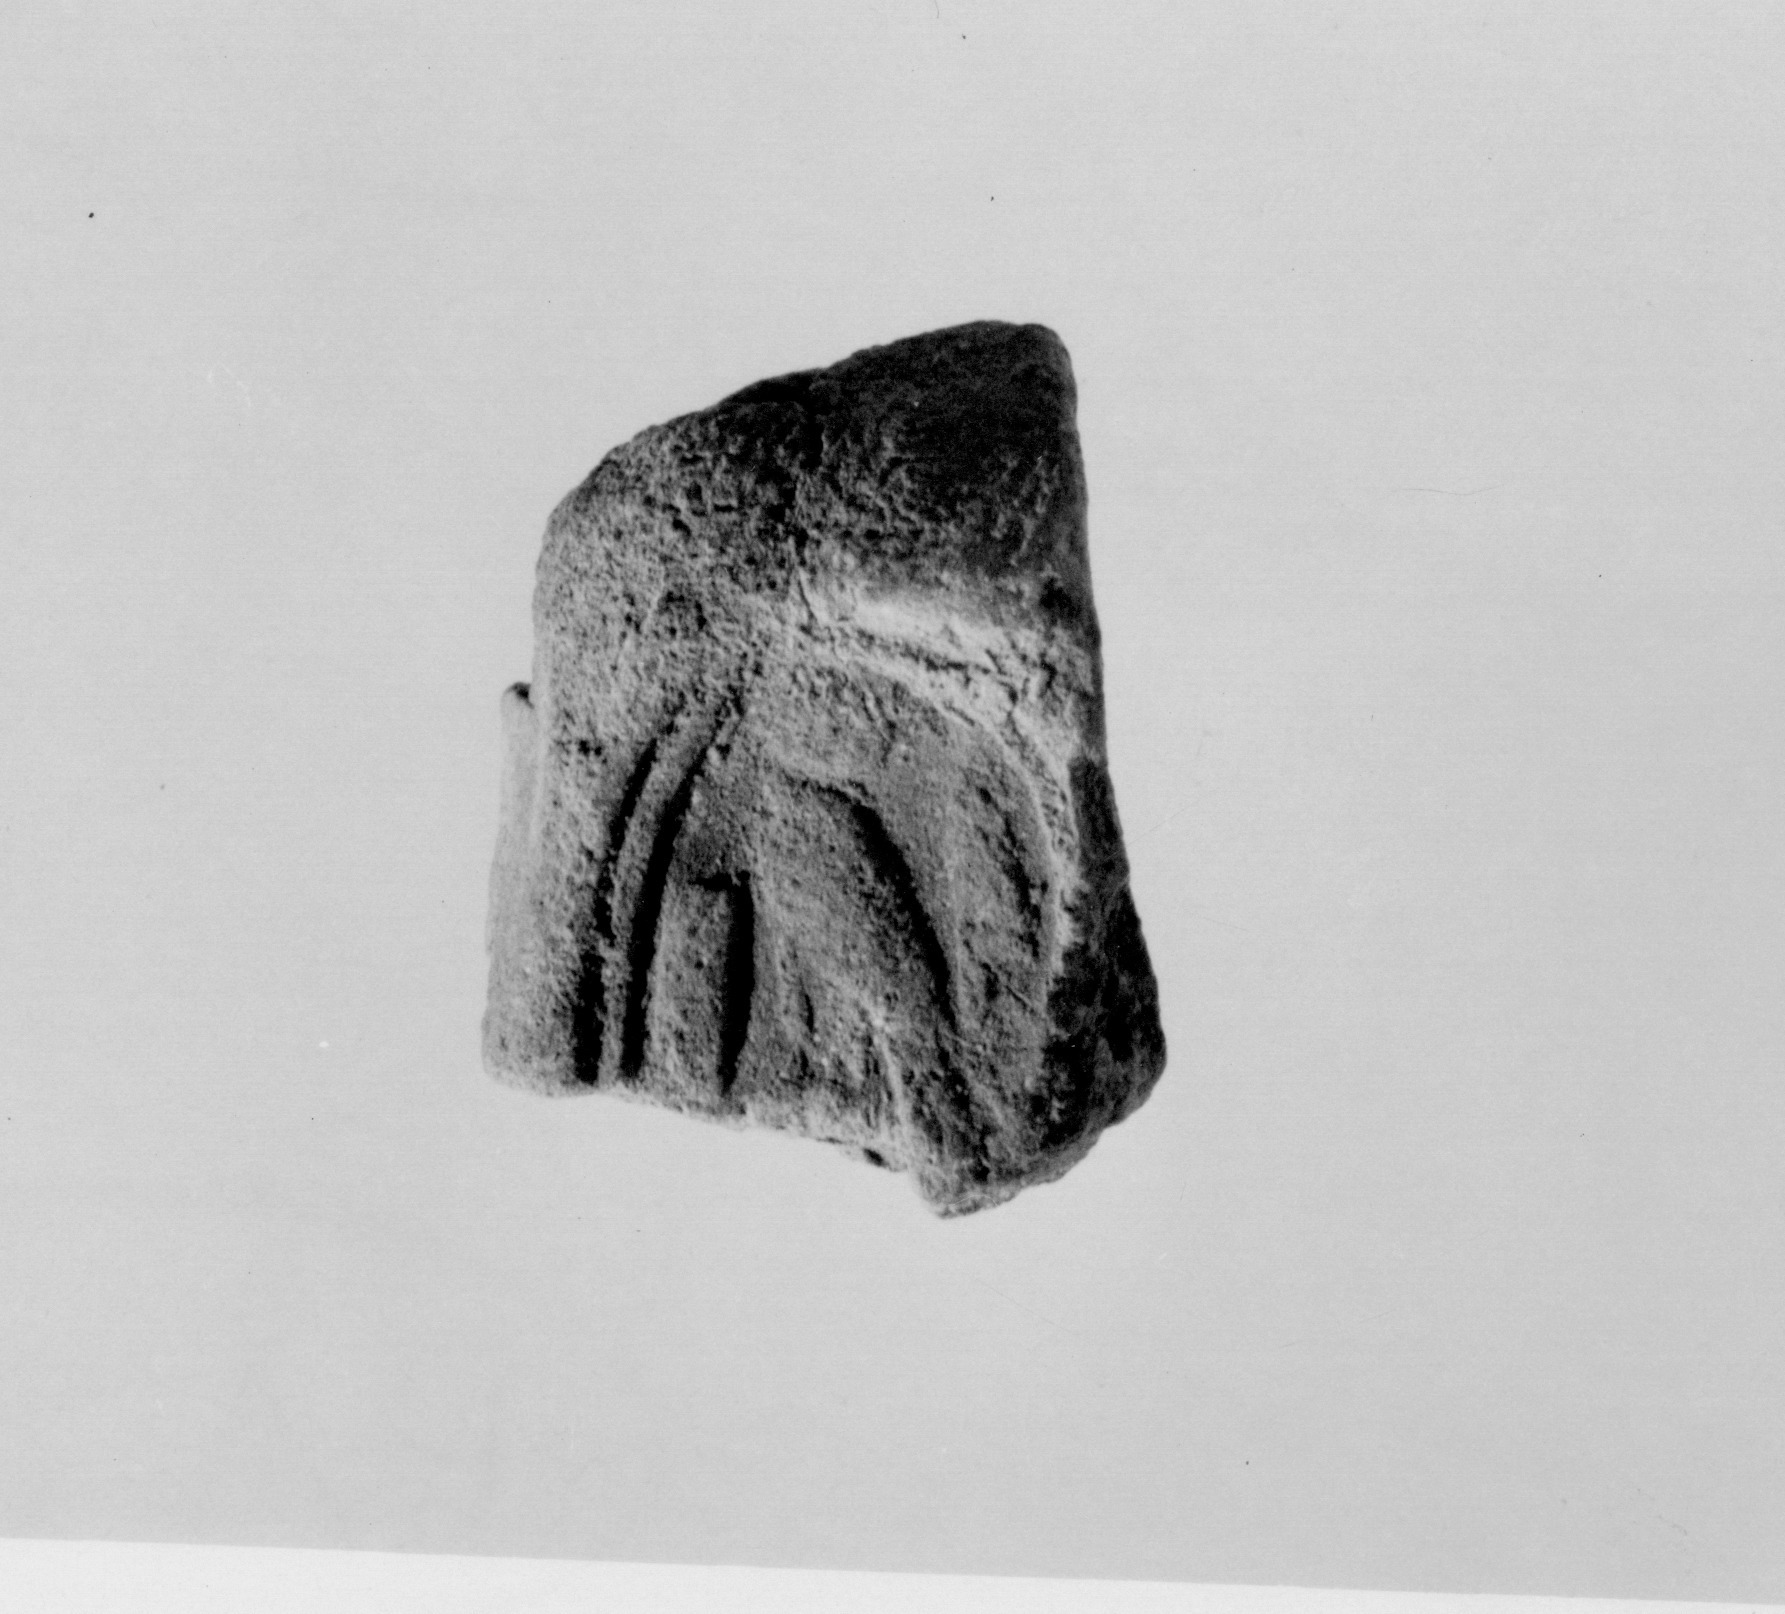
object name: sealing, nebmaatre, amenhotep iii, horus, falcon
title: Document Sealing With the Throne Name of Amenhotep III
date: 1390-1352 BCE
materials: mud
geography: egypt